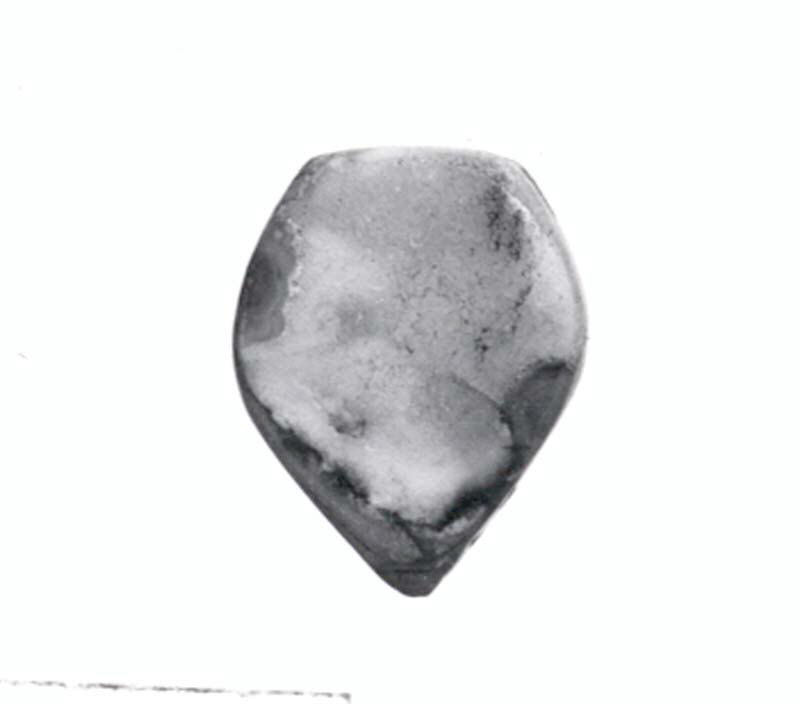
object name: pendant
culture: sasanian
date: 201-700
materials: stone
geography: iran